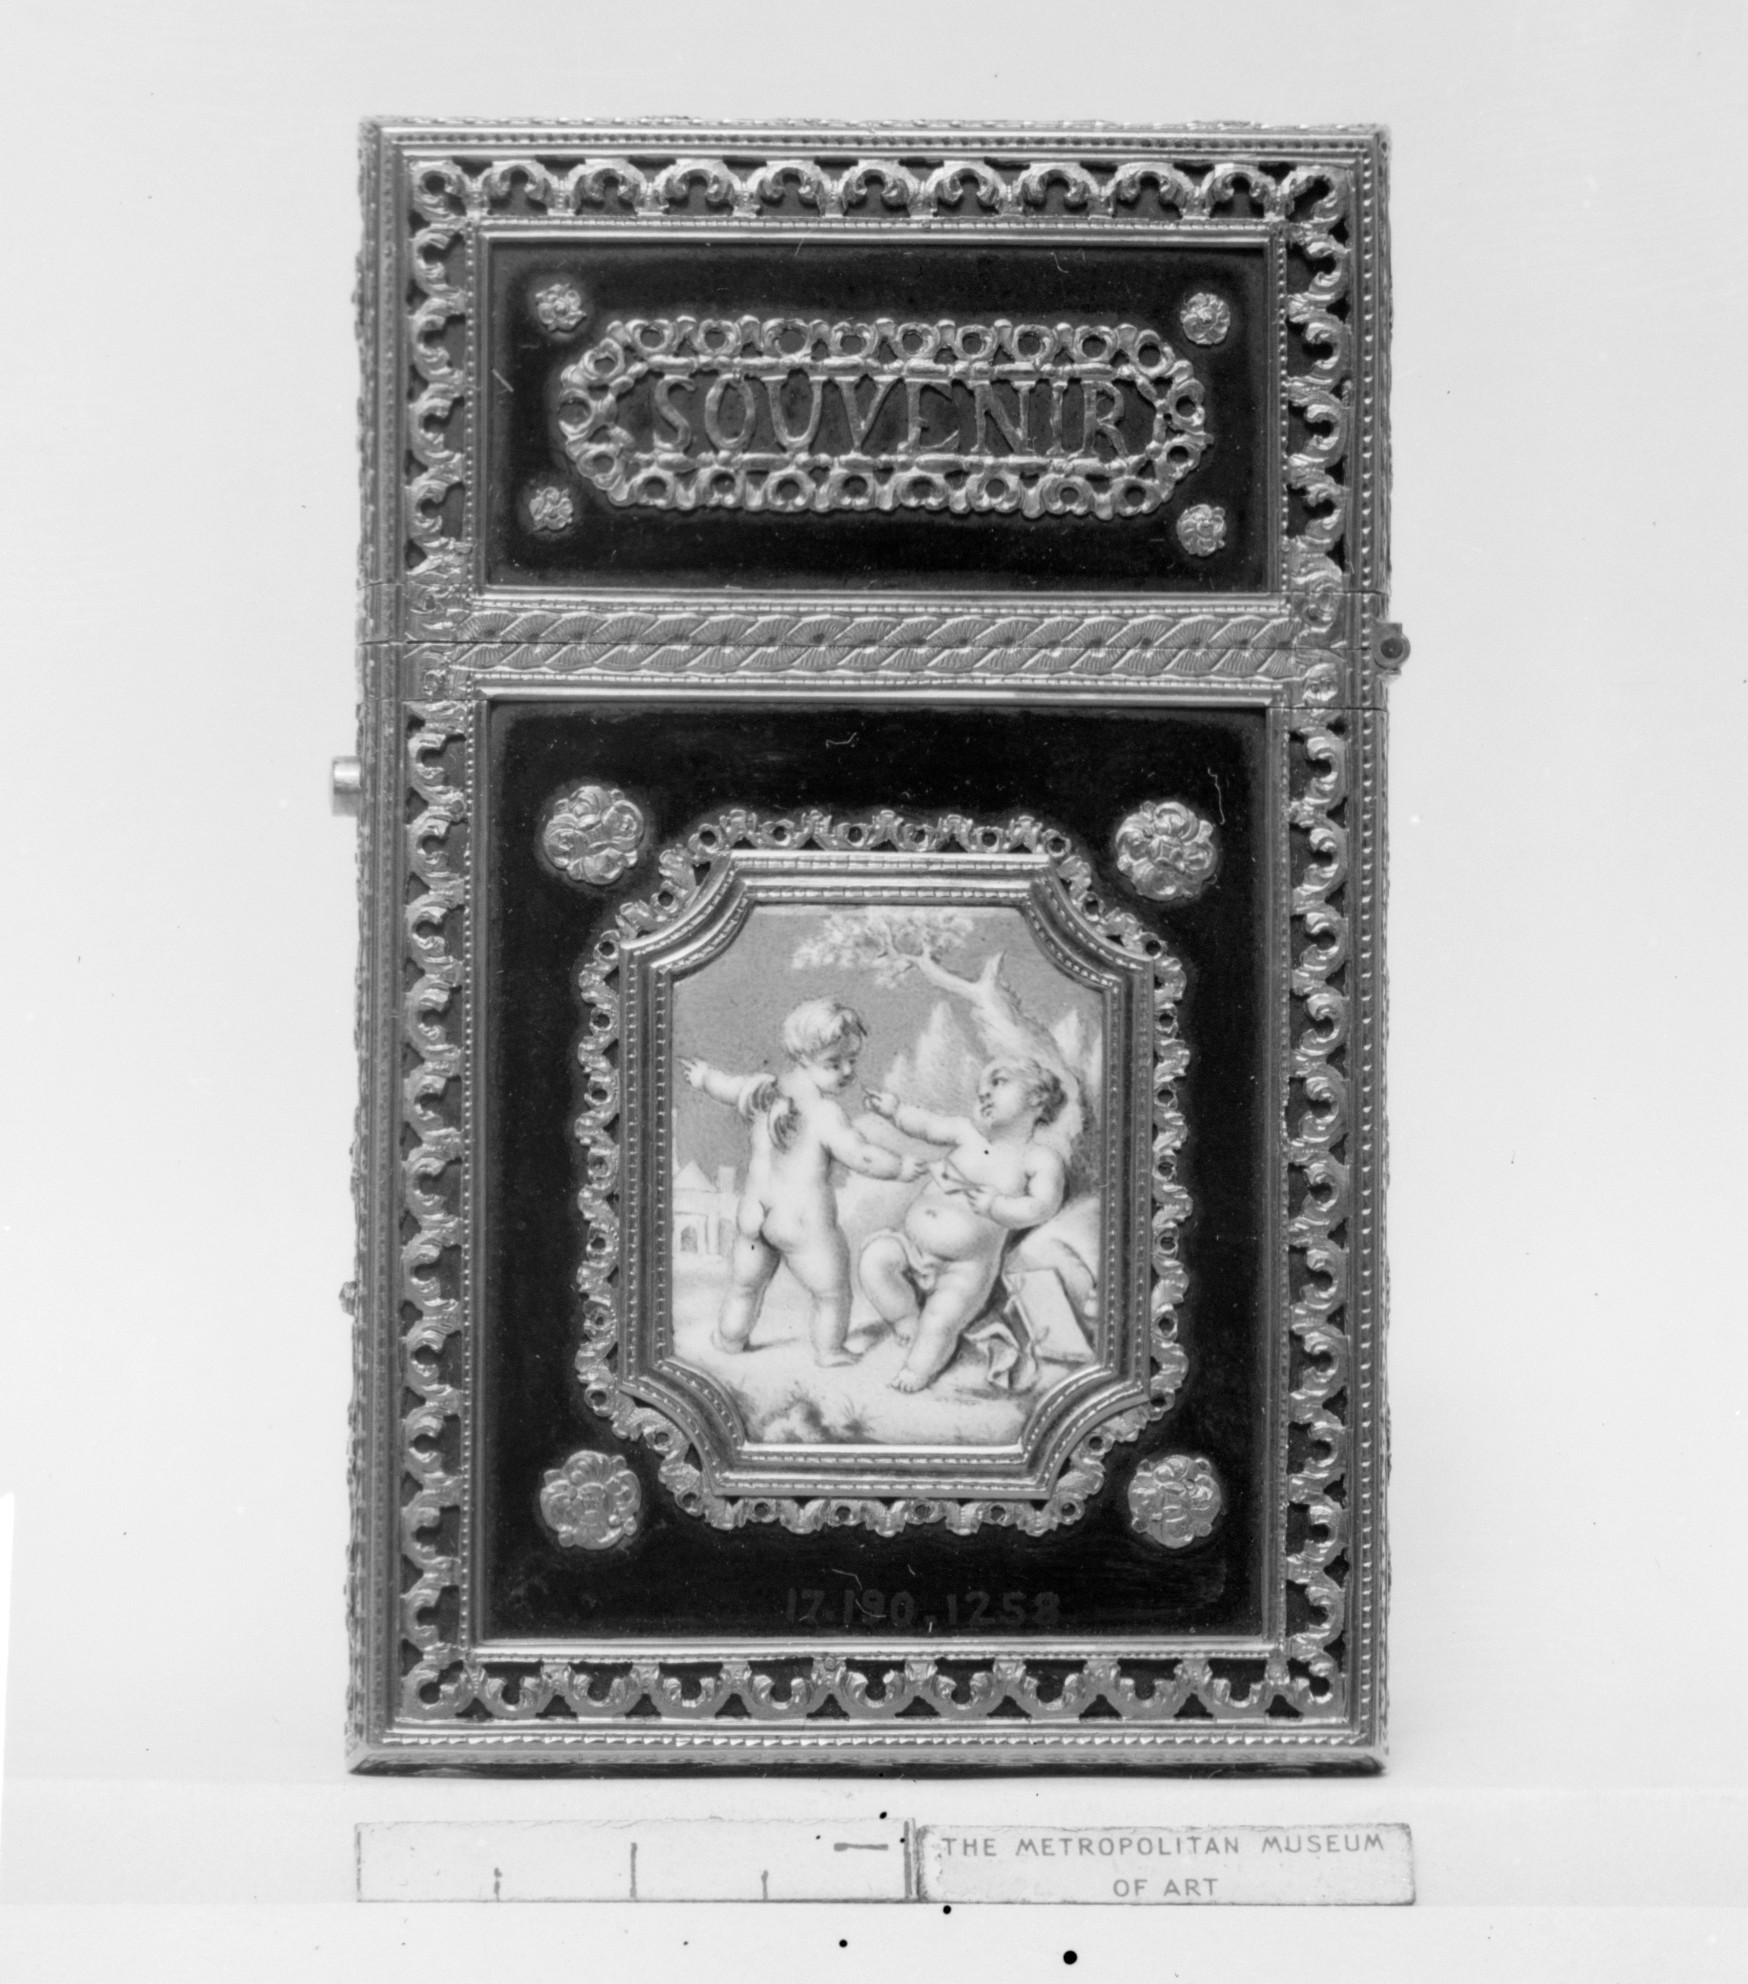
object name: souvenir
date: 1768-1774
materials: enamel, gold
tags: cupid